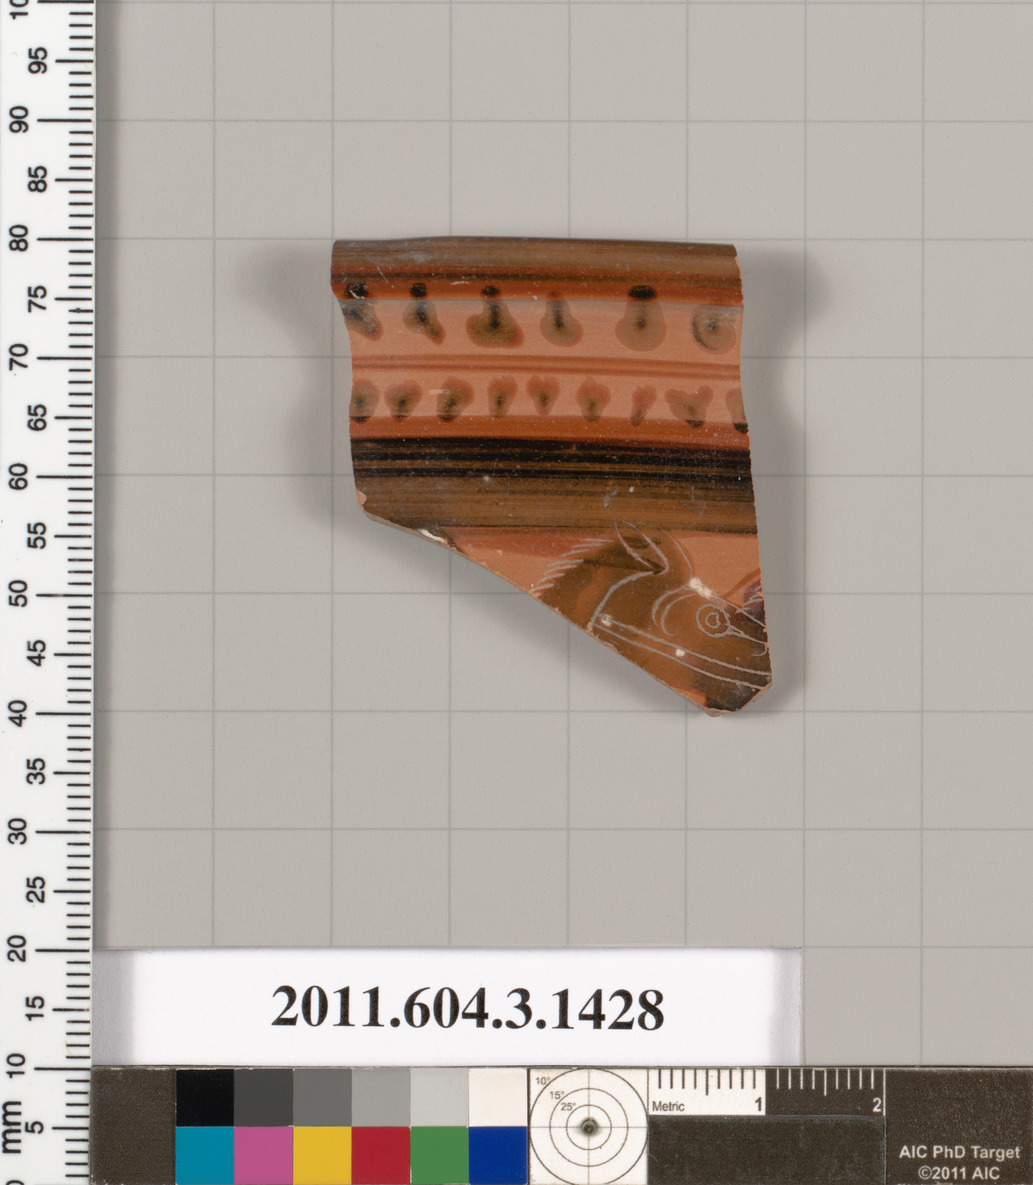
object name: skyphos fragment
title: Terracotta rim fragment of a skyphos (deep drinking cup)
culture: greek, attic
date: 534-468 BCE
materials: terracotta